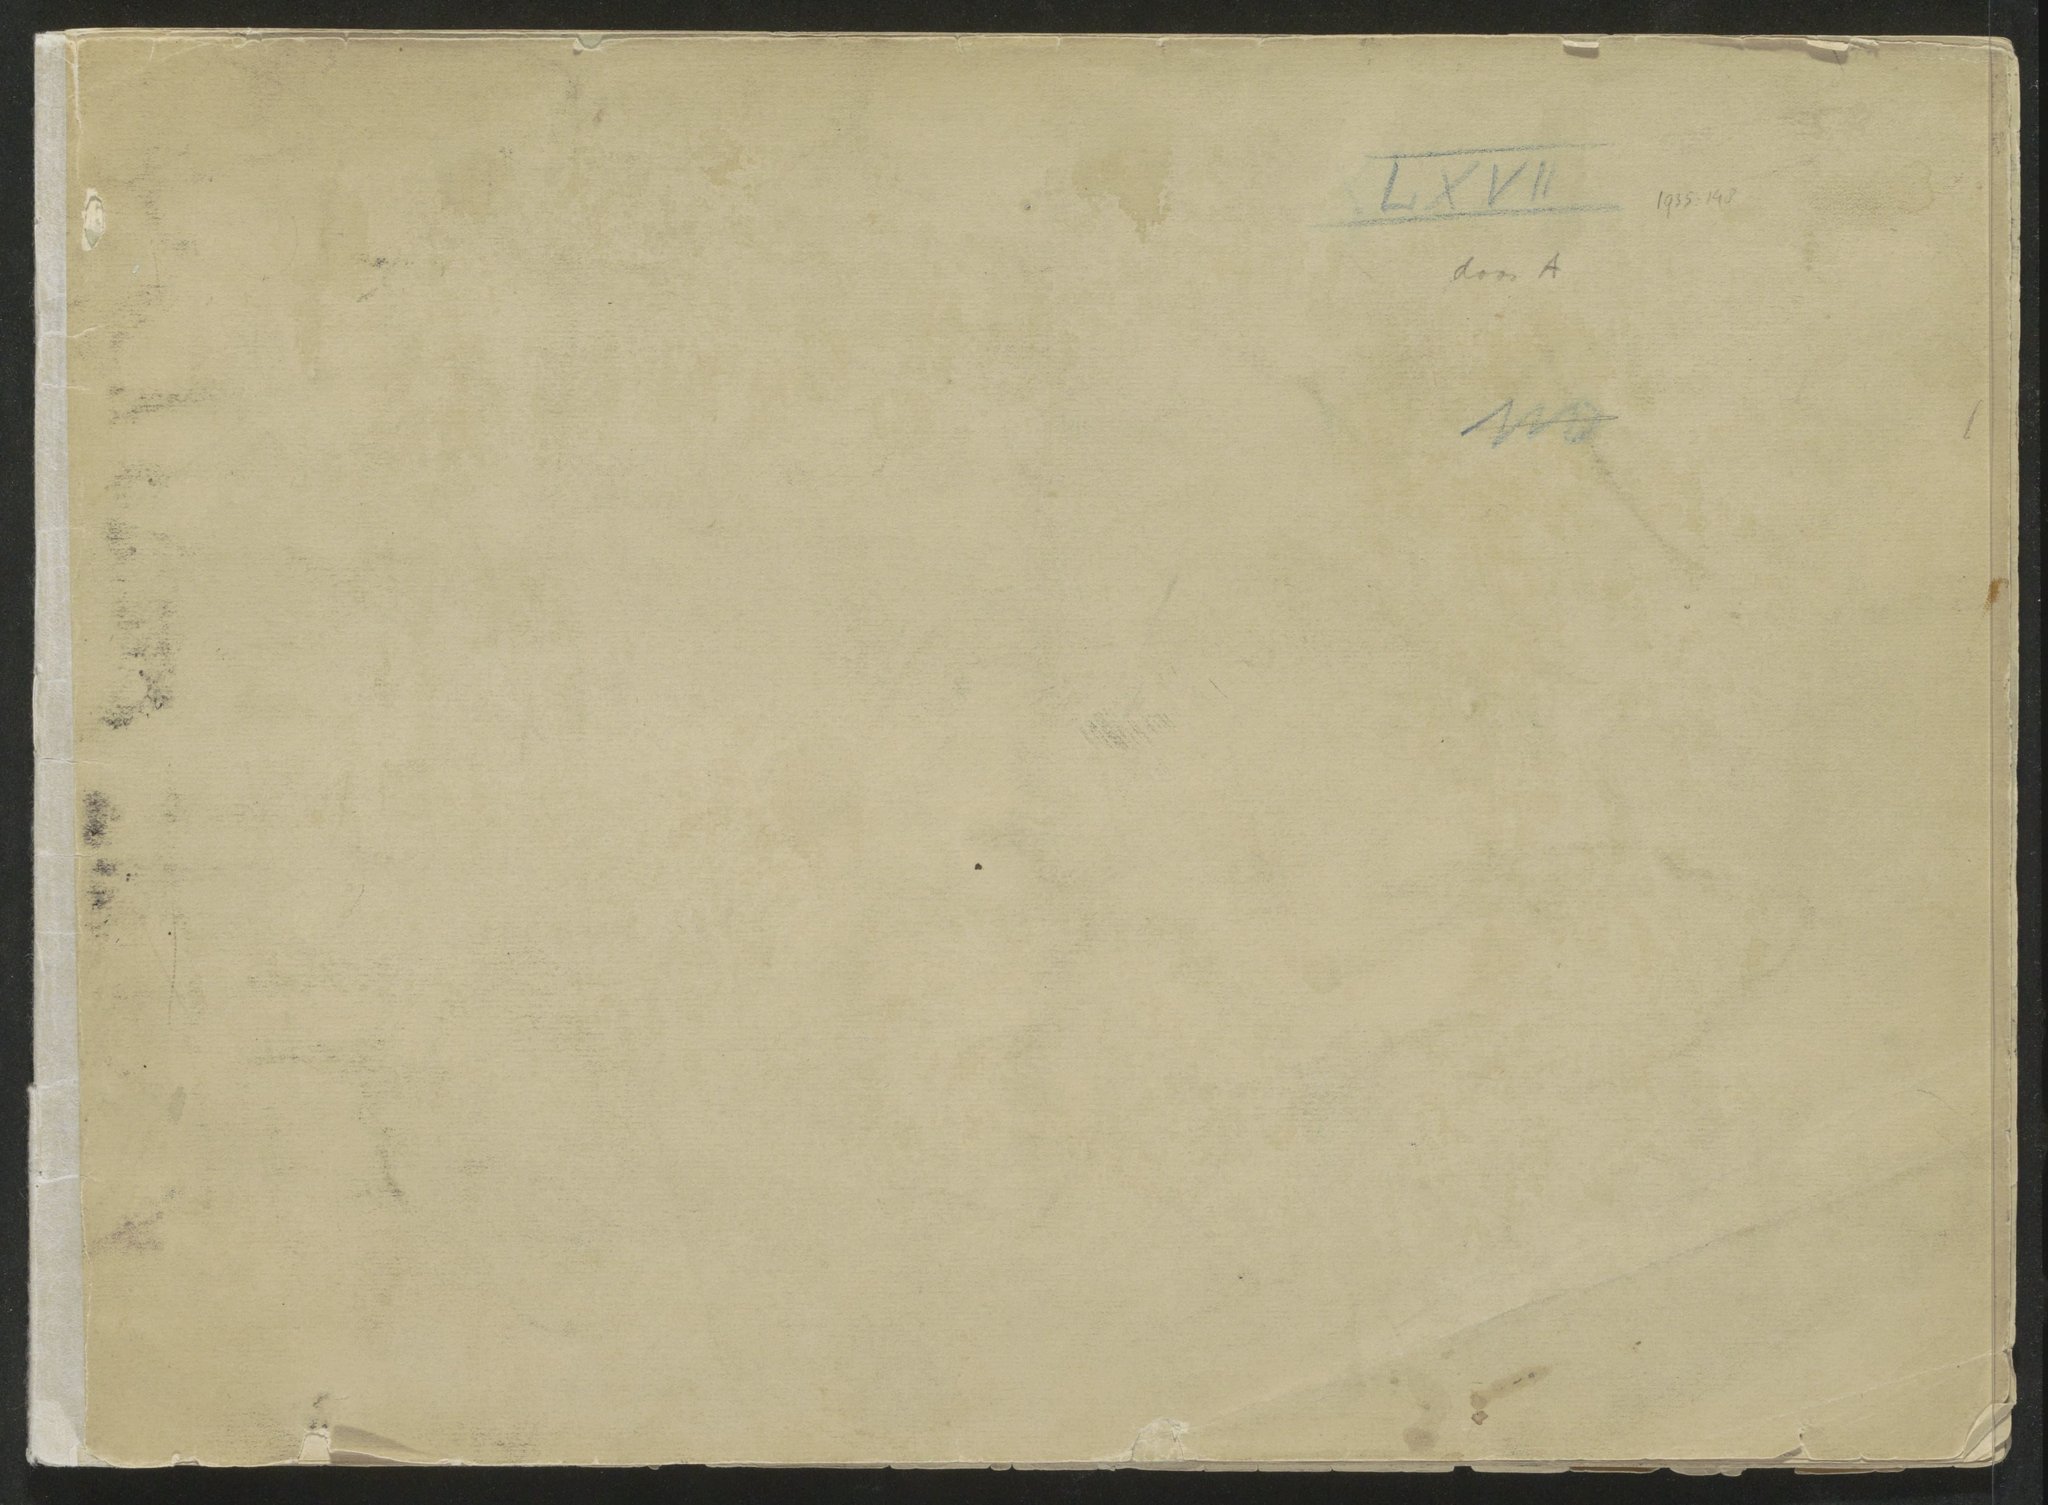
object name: sketchbook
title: Schetsboek LXVII met 11 bladen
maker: isaac israels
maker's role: draughtsman, painter, print maker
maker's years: 1865-1934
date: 1886-1934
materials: chalk, paper, watercolor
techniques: brush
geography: amsterdam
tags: adult woman, the (nude) human figure; 'corpo humano' (ripa) - aa - female human figure, anonymous historical person portrayed - bb - woman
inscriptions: collector's mark: Lugt 2228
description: Schetsboek nr. LXVII bestaande uit 11 bladen met vrouwelijke naakten en portretten van vrouwen. Op de achterzijde van de kaft een studie.